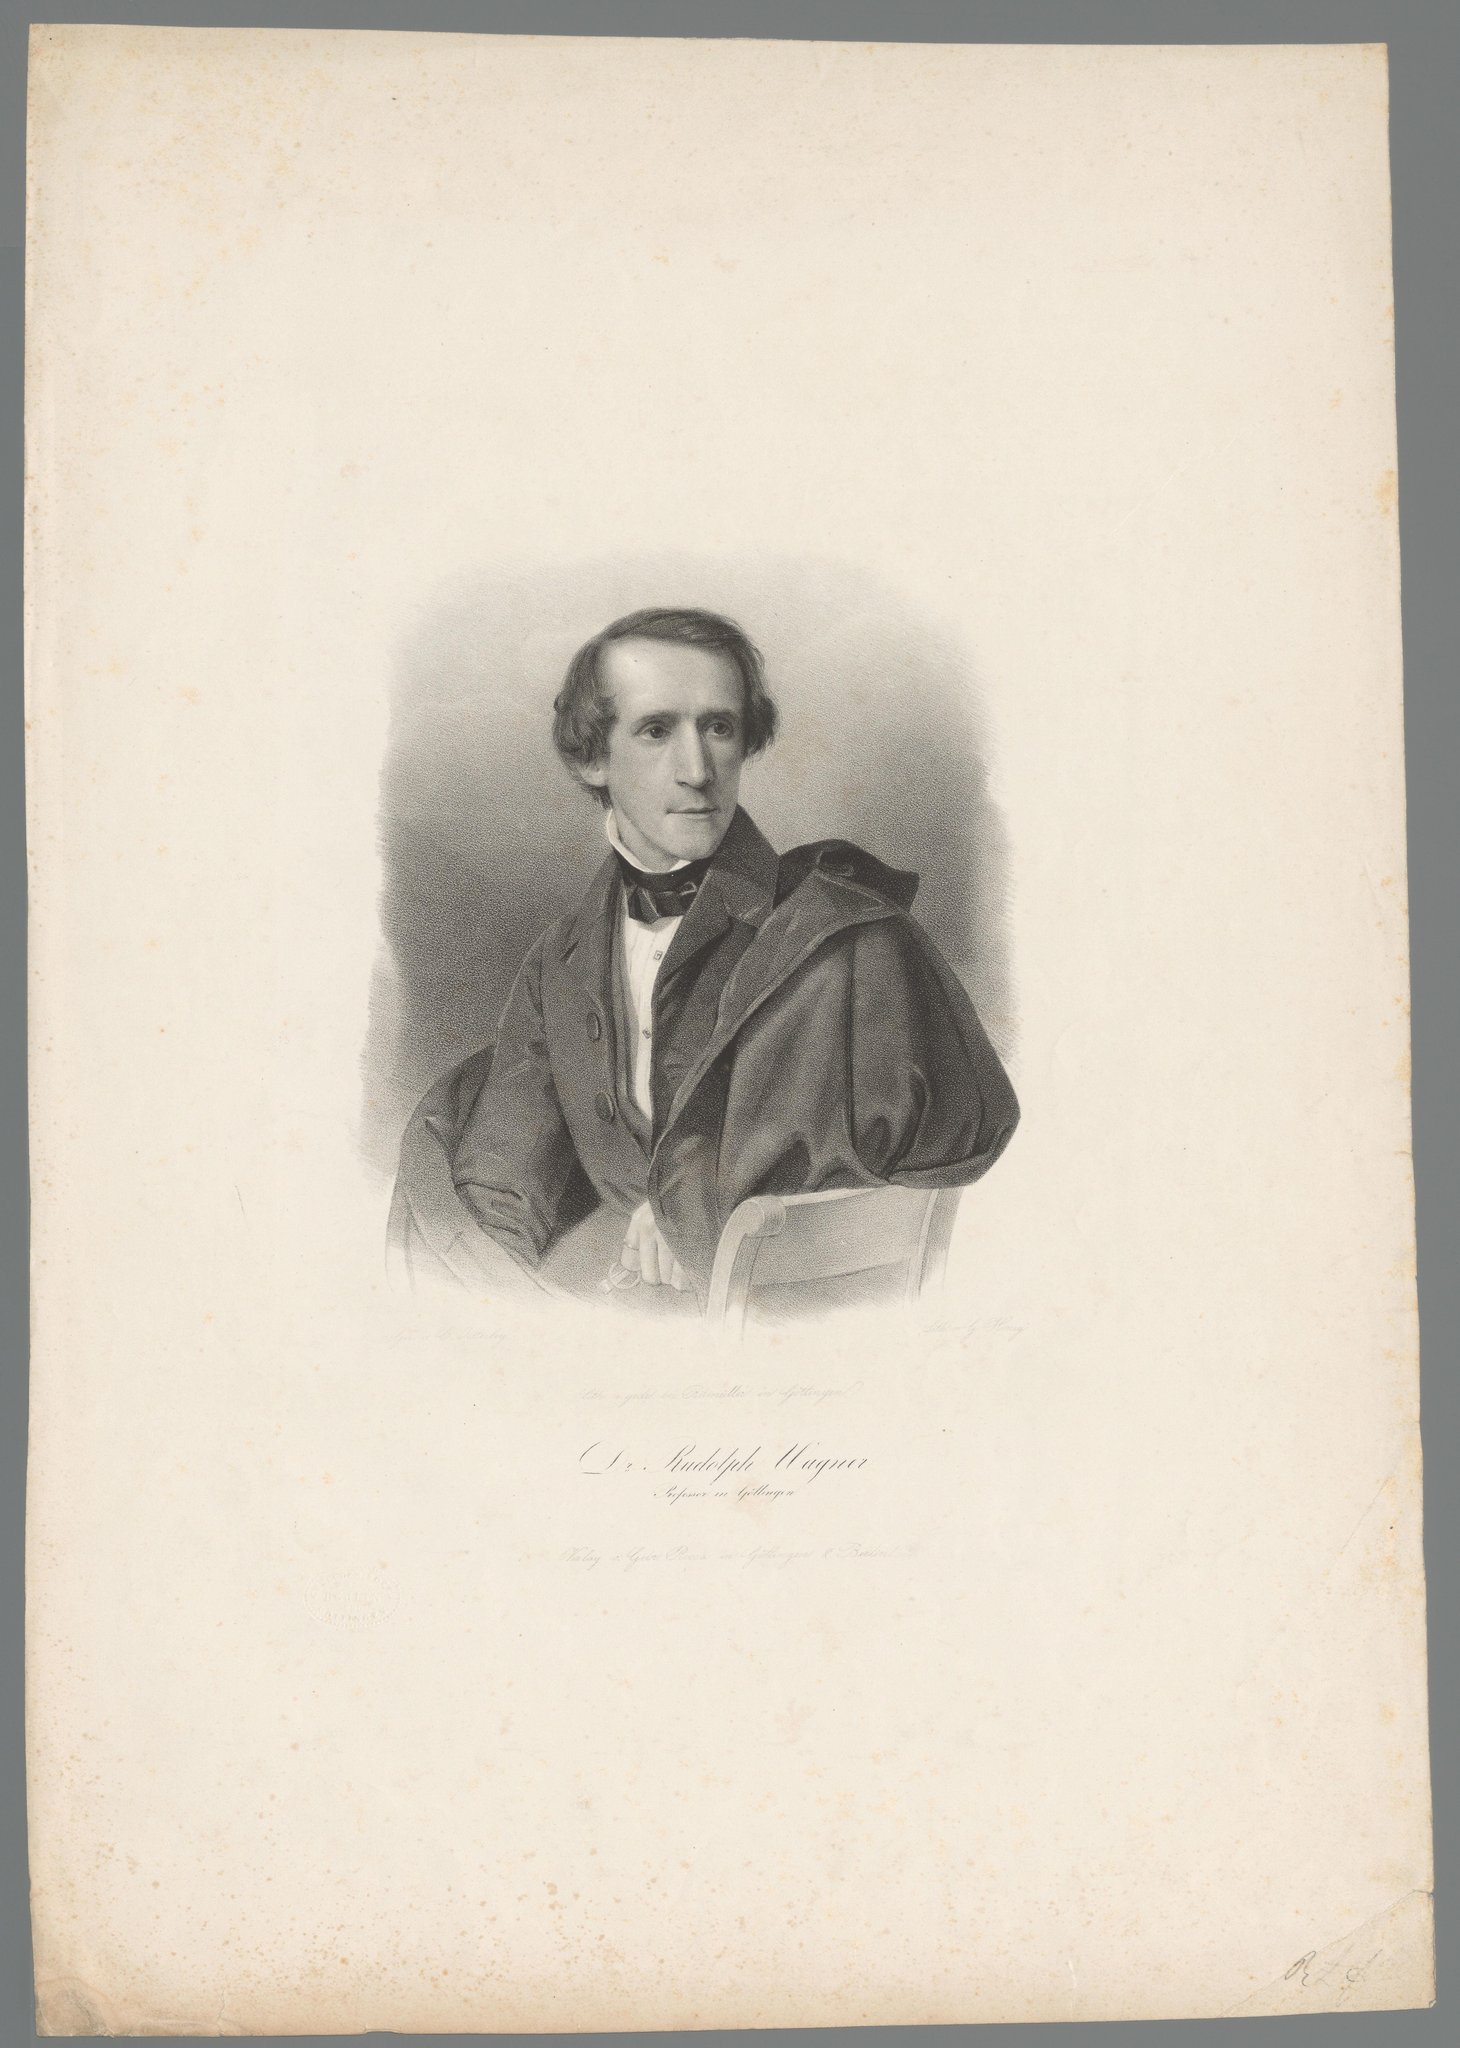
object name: print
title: Dr. Rudolph Wagner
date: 1820-1850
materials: paper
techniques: lithograph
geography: gottingen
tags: adult man, historical persons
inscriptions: check stamp: Lugt 5514, collector's mark: Lugt 2228